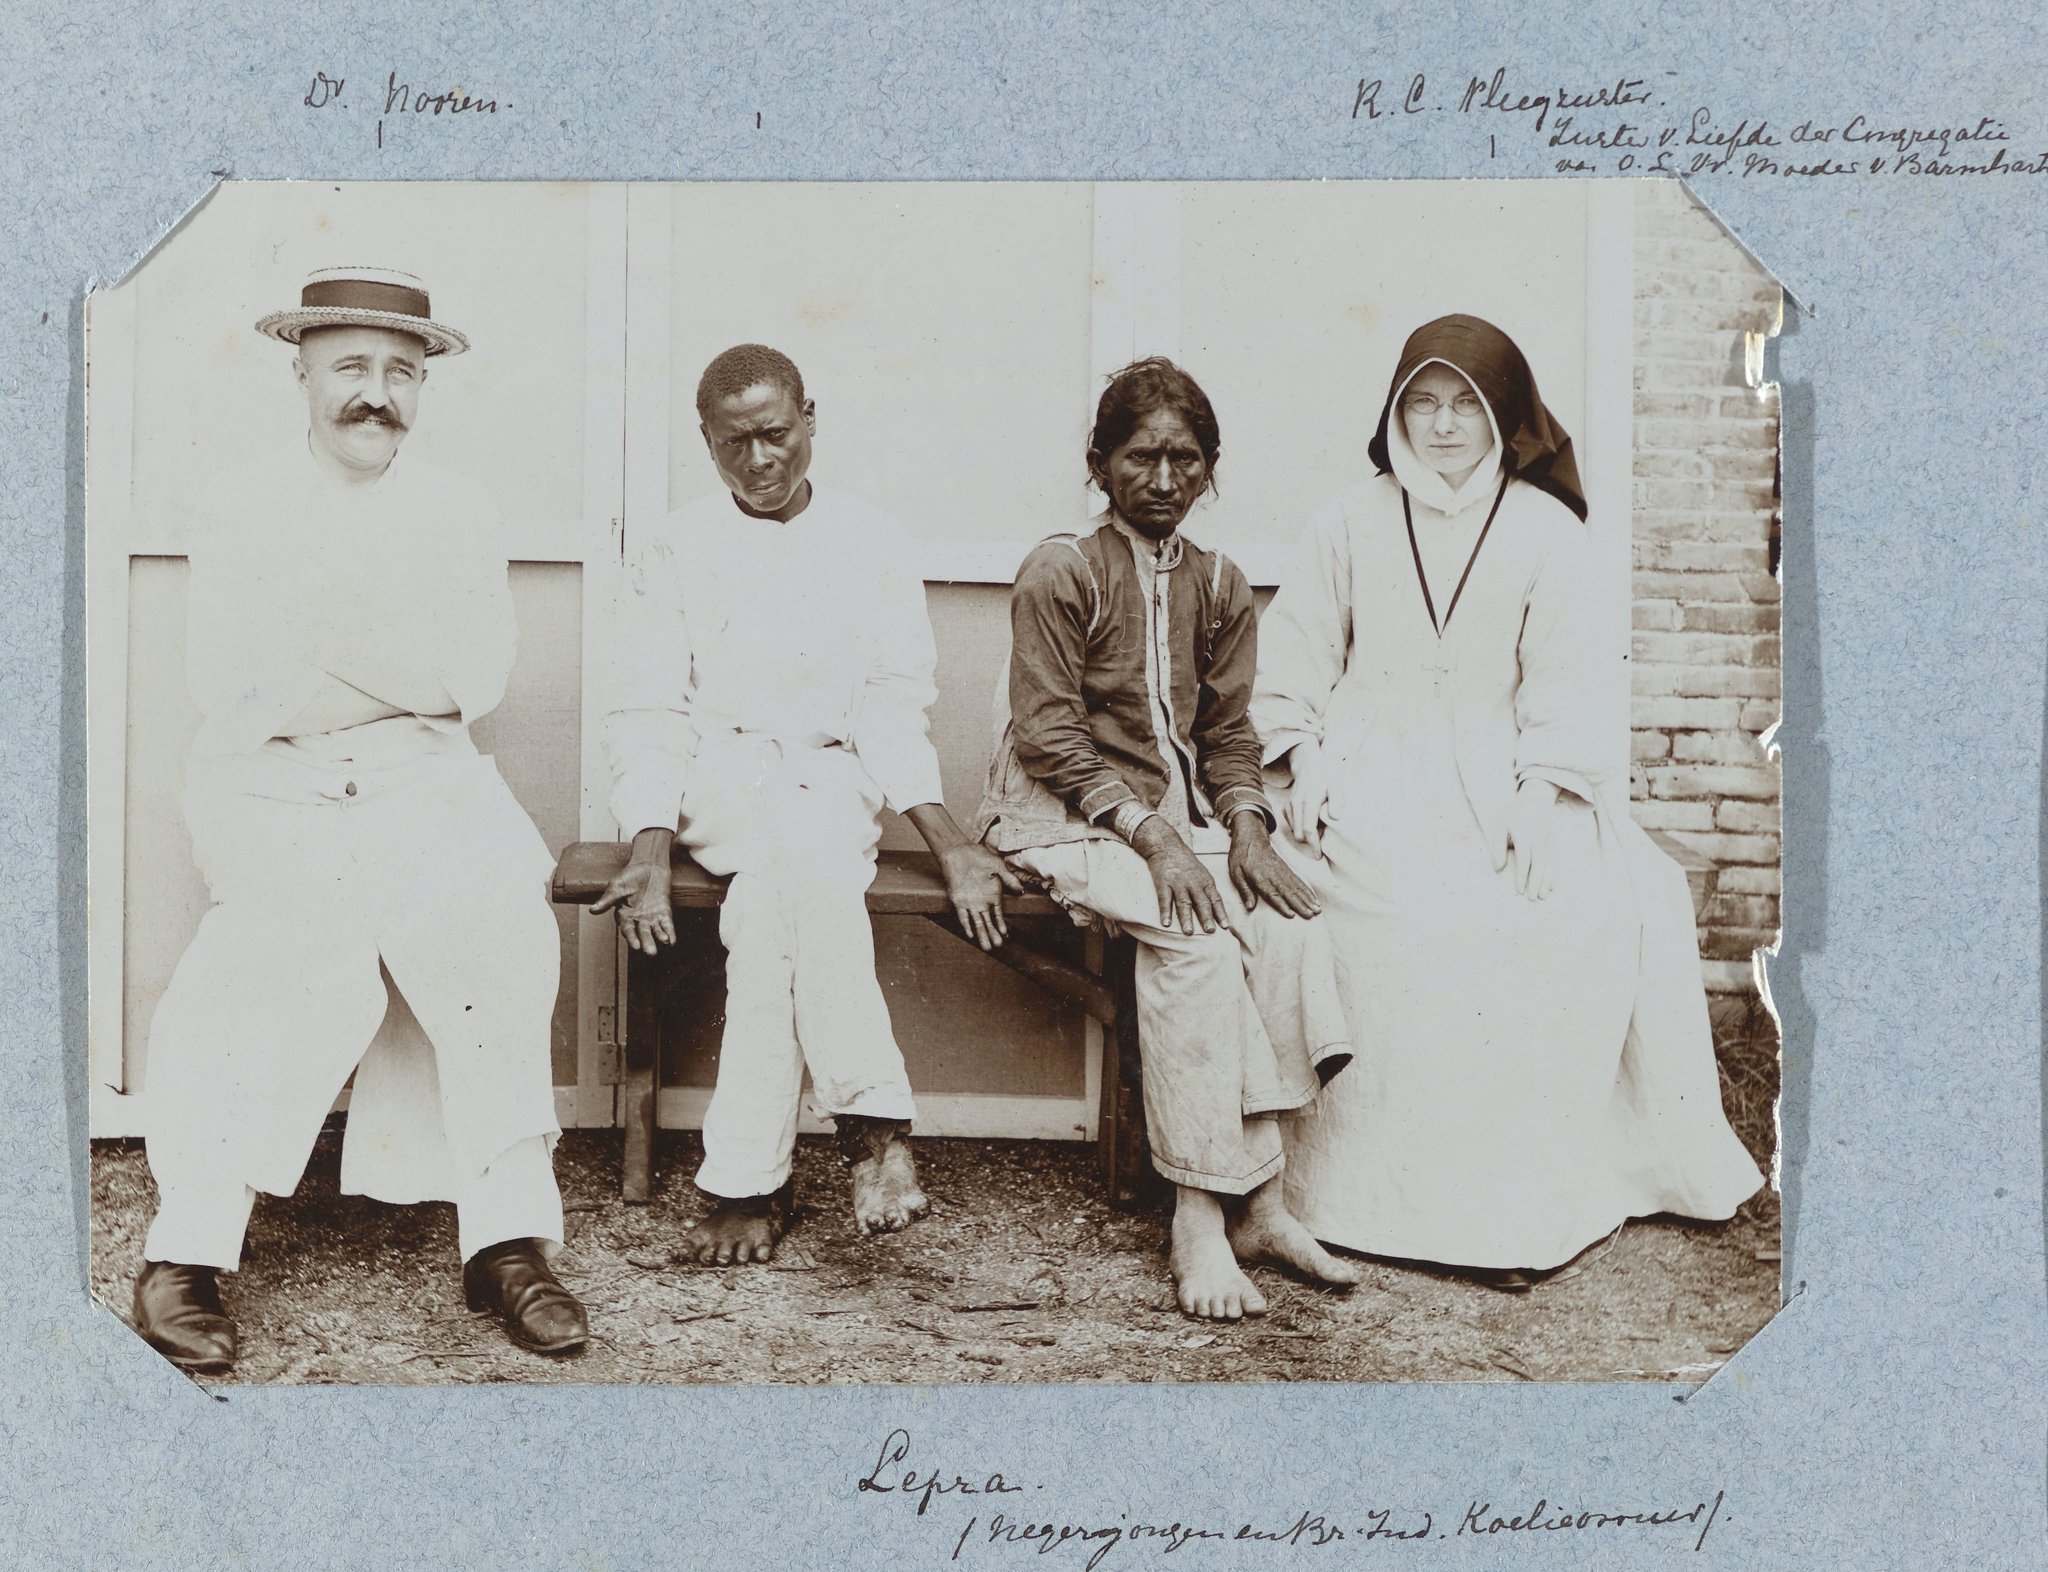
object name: photograph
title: Lepra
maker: théodore van lelyveld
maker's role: painter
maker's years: 1867-1954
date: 1895-1898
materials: photographic support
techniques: collodion silver print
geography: suriname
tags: patient, sick person, leprosy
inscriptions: inscription: ‘Lepra (negerjongen en Br. Ind. Koelievrouw) / Dr. Nooren / R.C. Pleegzuster. Zuster v. Liefde der Congregatie van O.L. Vr. Moeder van Barmhartigh.’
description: Twee leprapatienten met dokter Nooren en een pleegzuster. Een Marron man en een Brits-Indische vrouw met tekenen van lepra op handen en voeten. Waarschijnlijk patiënten in het hospitaal te Paramaribo. Fotoafdruk in een fotoalbum van Théodore van Lelyveld over Suriname uit 1895-1898.